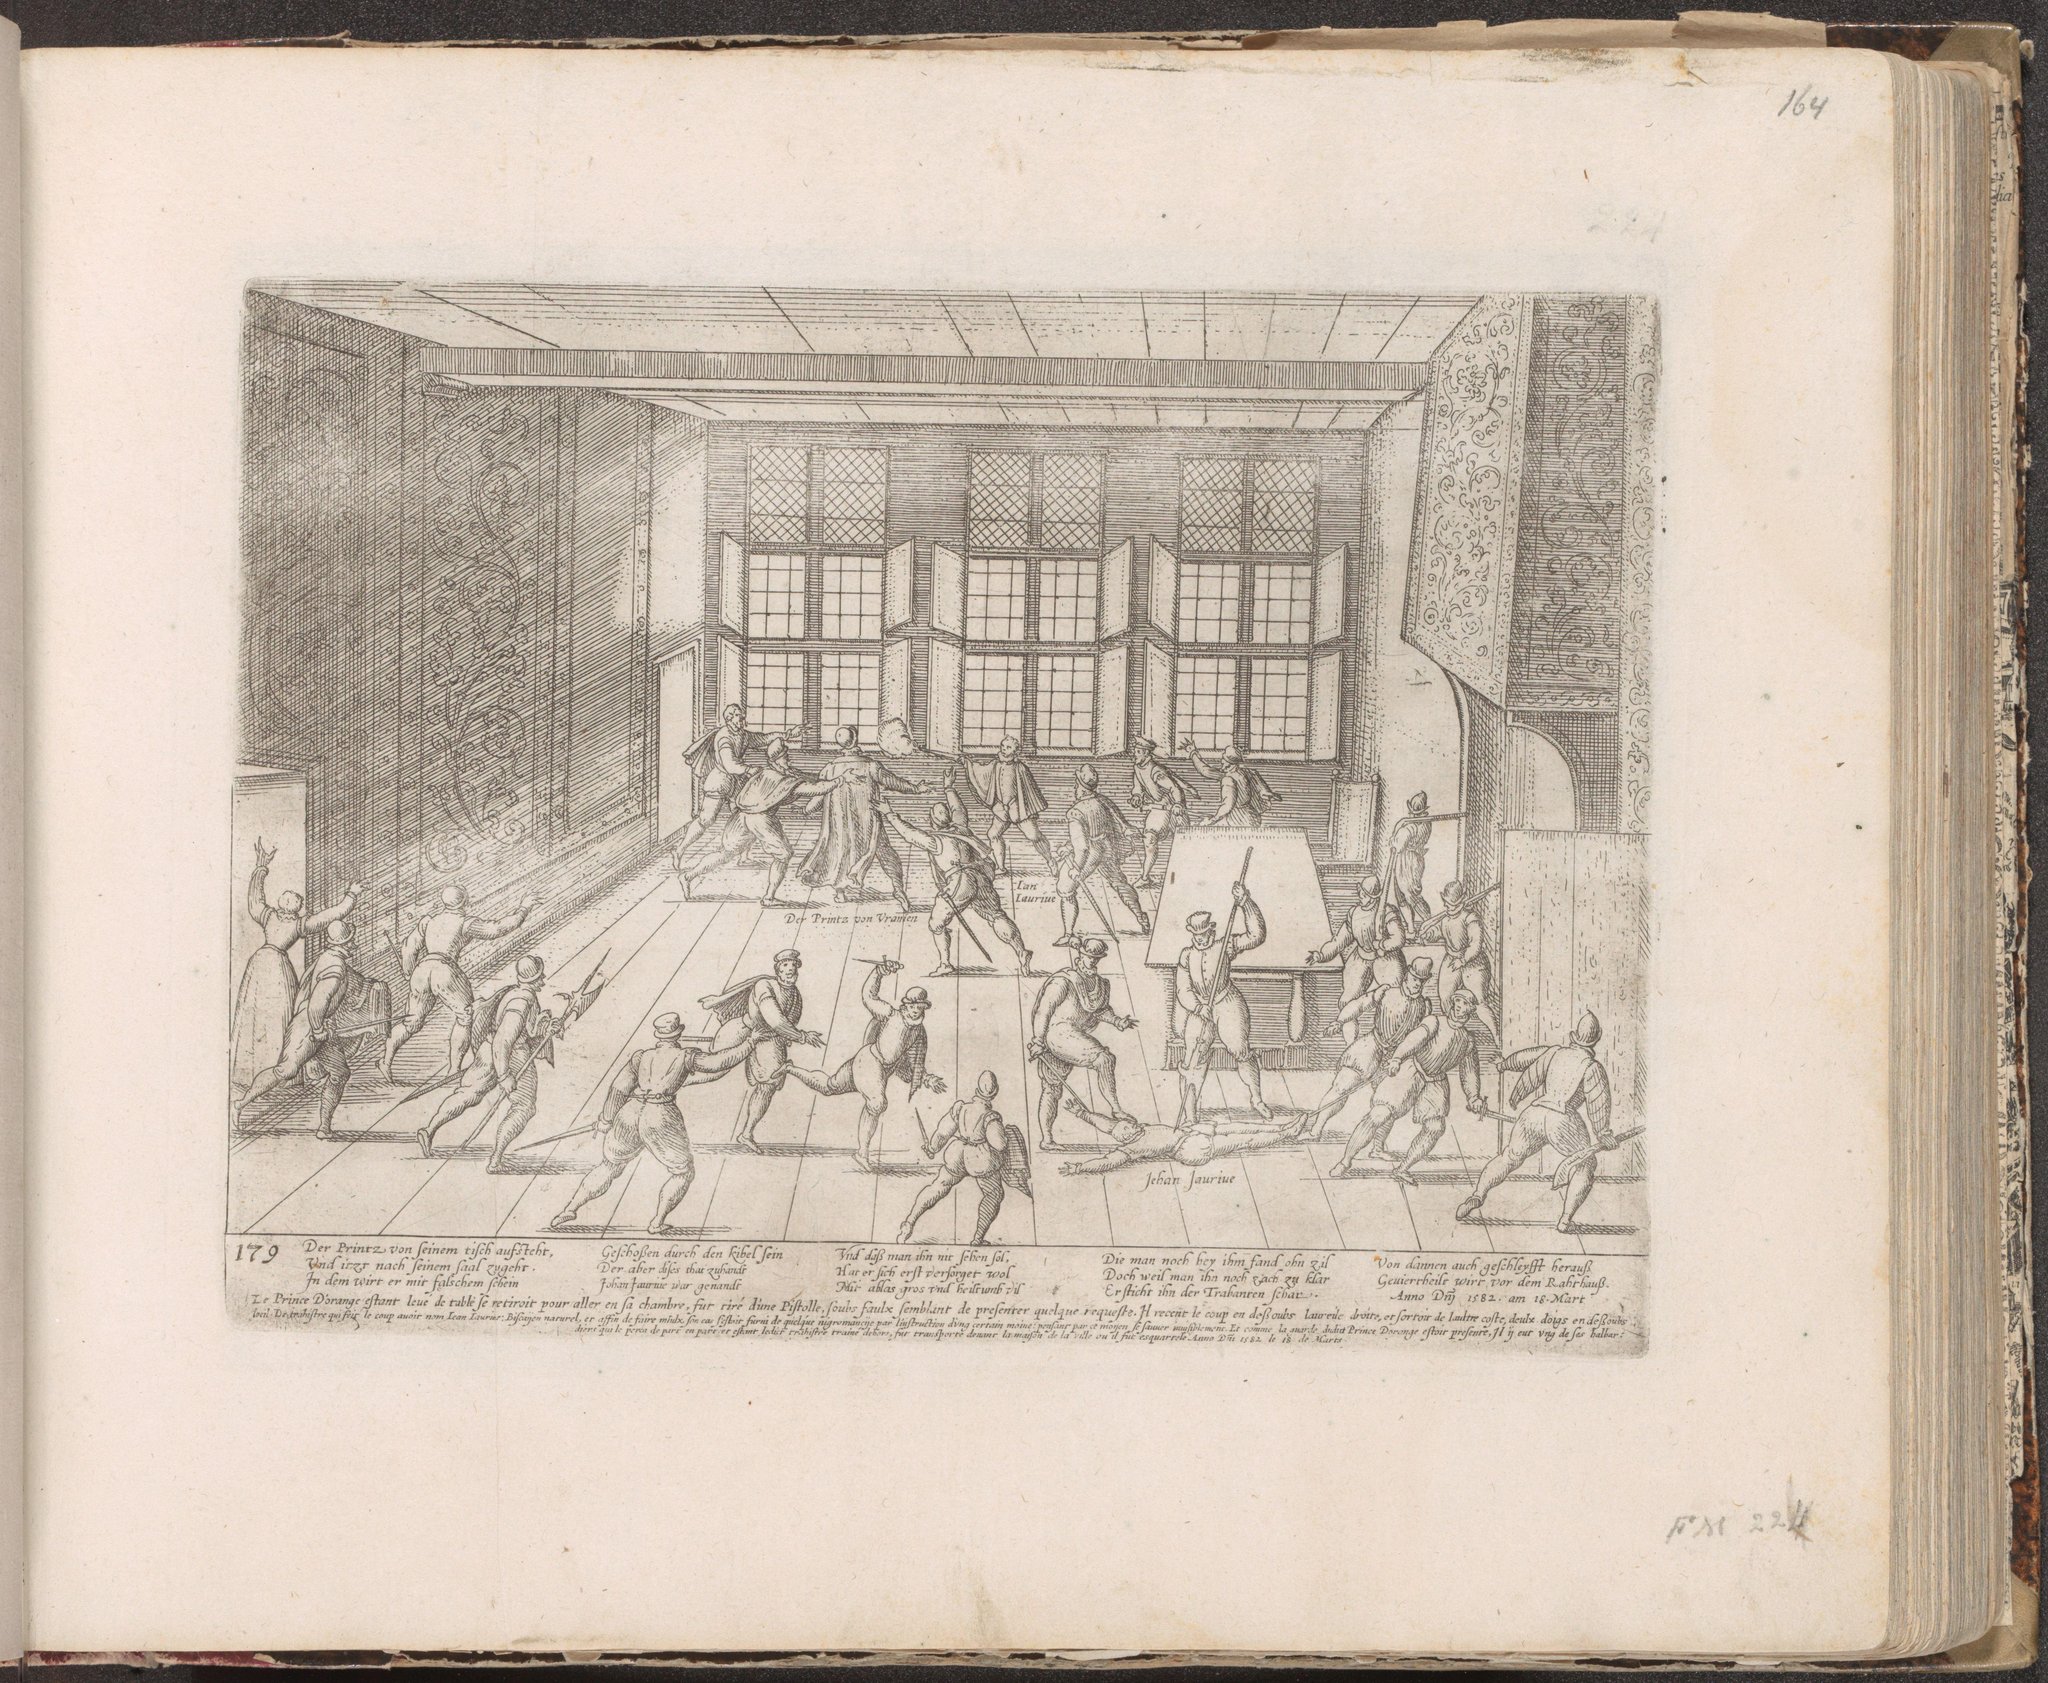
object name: history print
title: Aanslag door Jean de Jauregui op Willem van Oranje, 1582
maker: frans hogenberg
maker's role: print maker, publisher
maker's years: 1538-1590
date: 1582-1585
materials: paper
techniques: etching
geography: cologne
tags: william i (prince of orange), attempt, political murder, antwerp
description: Moordaanslag door Jean de Jauregui op Willem van Oranje te Antwerpen, 18 maart 1582. In een interieur lost Jauegui een pistoolschot op de prins. Op de voorgrond wordt Jauregui door soldaten overmeesterd. Met onderschrift van 14 regels in het Duits en 3 regels in het Frans. Linksonder genummerd: 179. De prent maakt deel uit van een album.